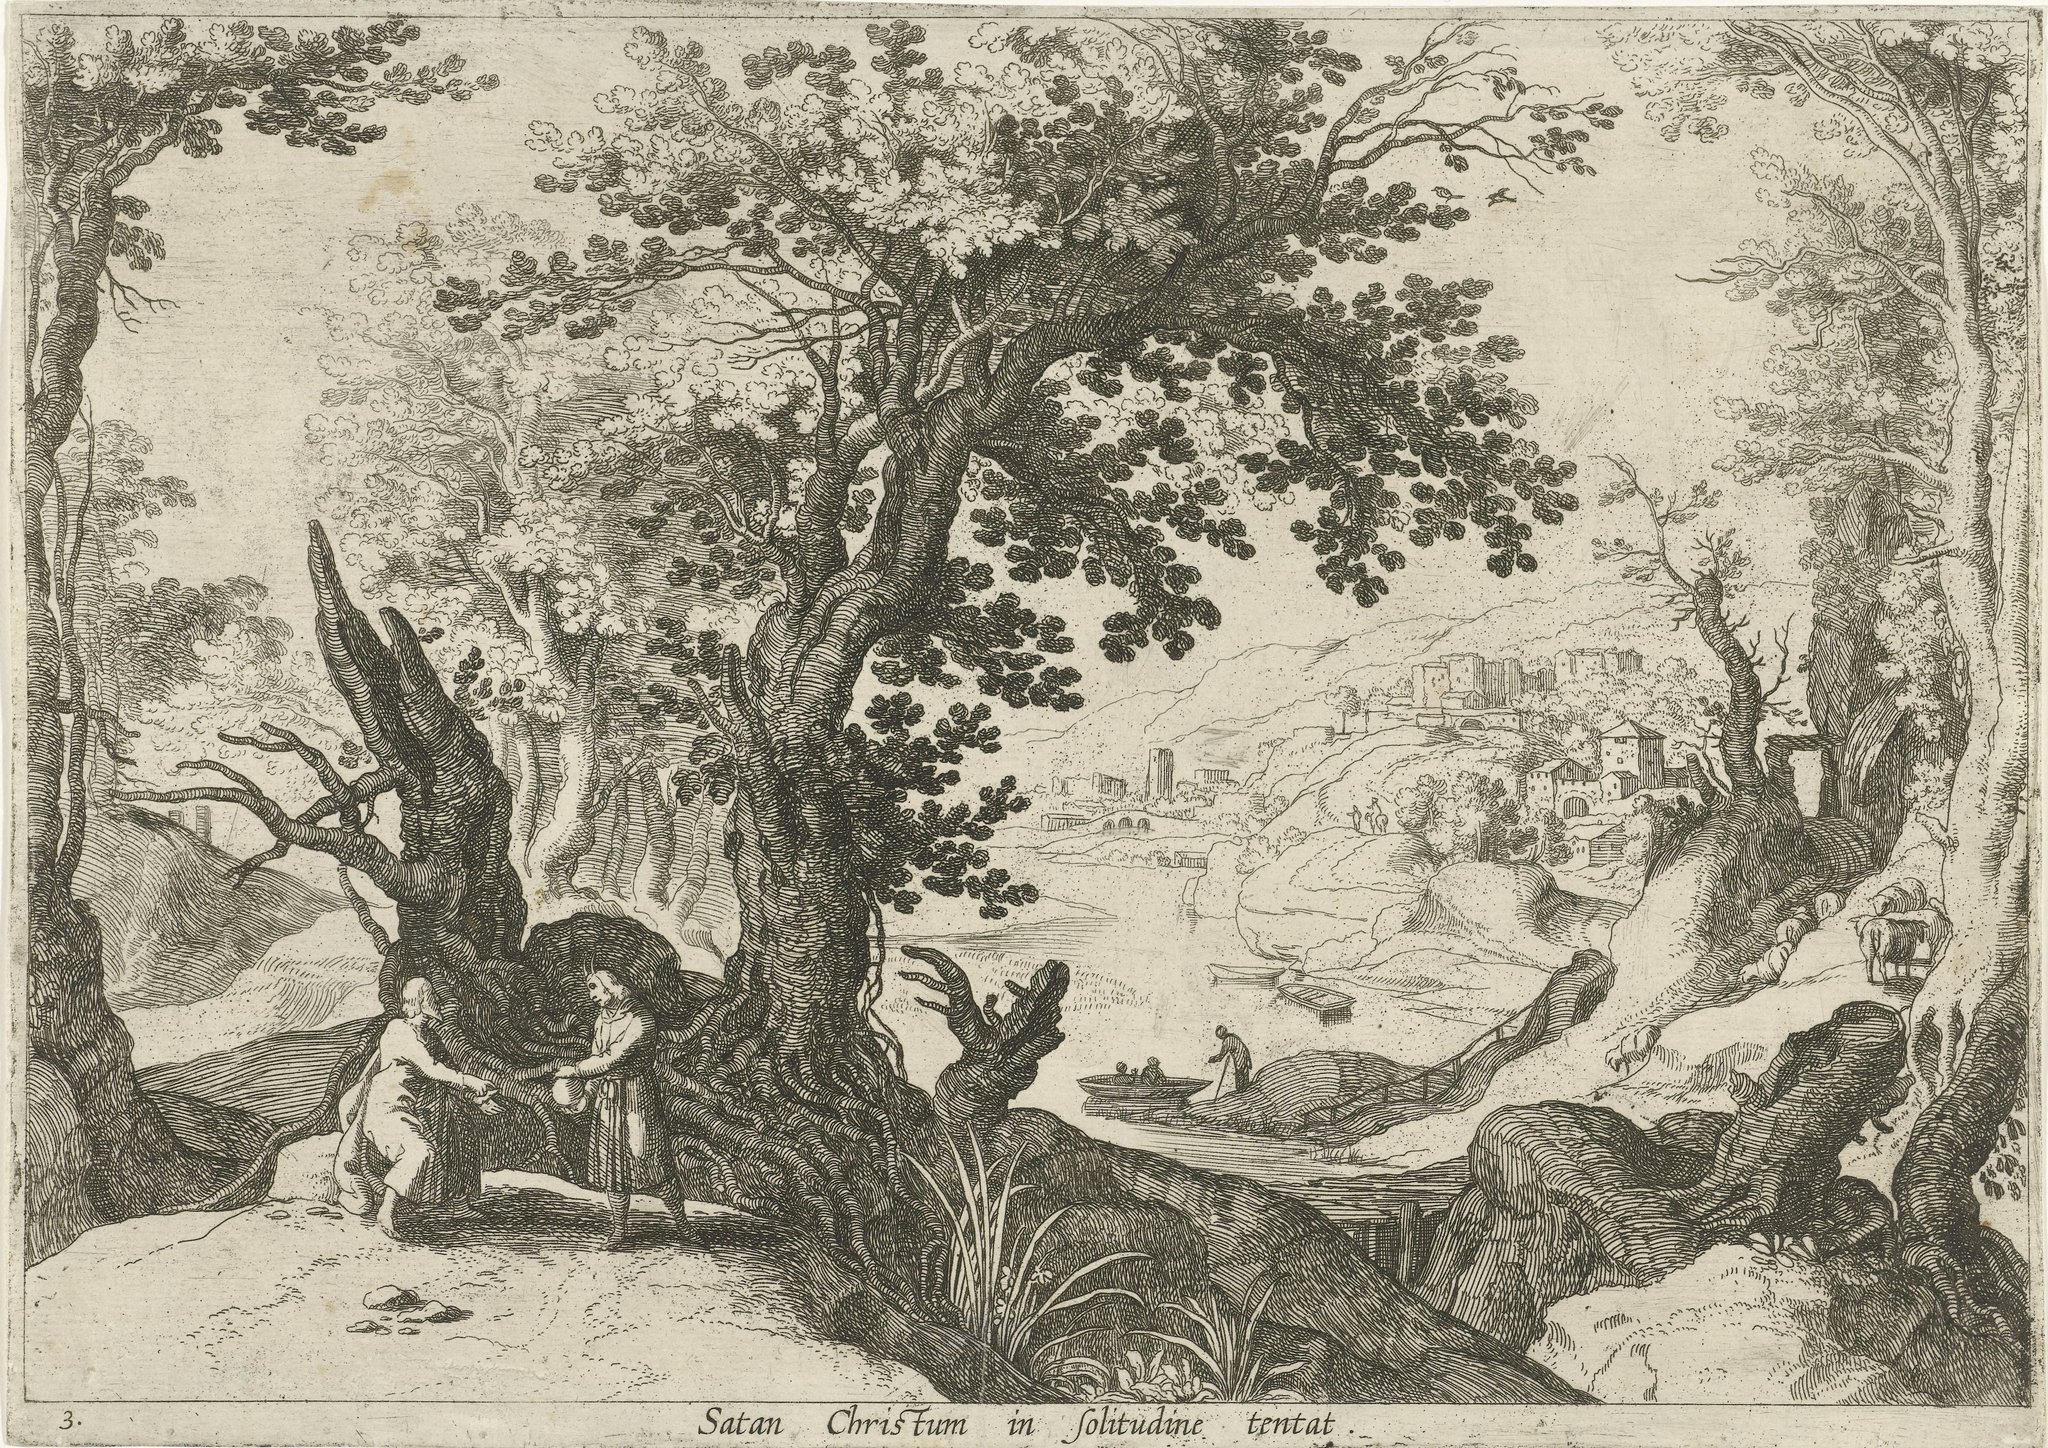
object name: print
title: Italiaanse landschappen met Bijbelse voorstellingen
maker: guilliam van nieulandt (ii)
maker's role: draughtsman, print maker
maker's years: 1584-1635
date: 1606-1628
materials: paper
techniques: etching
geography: antwerp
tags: 'command these stones to become loaves of bread' ~ temptation of christ in the wilderness, river, rowing-boat, canoe, etc.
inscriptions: collector's mark: Lugt 2228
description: In een Italiaans landschap voor een boom wordt Christus door de duivel verzocht een steen in brood te veranderen. Op de achtergrond een rivier met twee mensen in een roeiboot en iemand op de oever. Rechts op de achtergrond een stad.